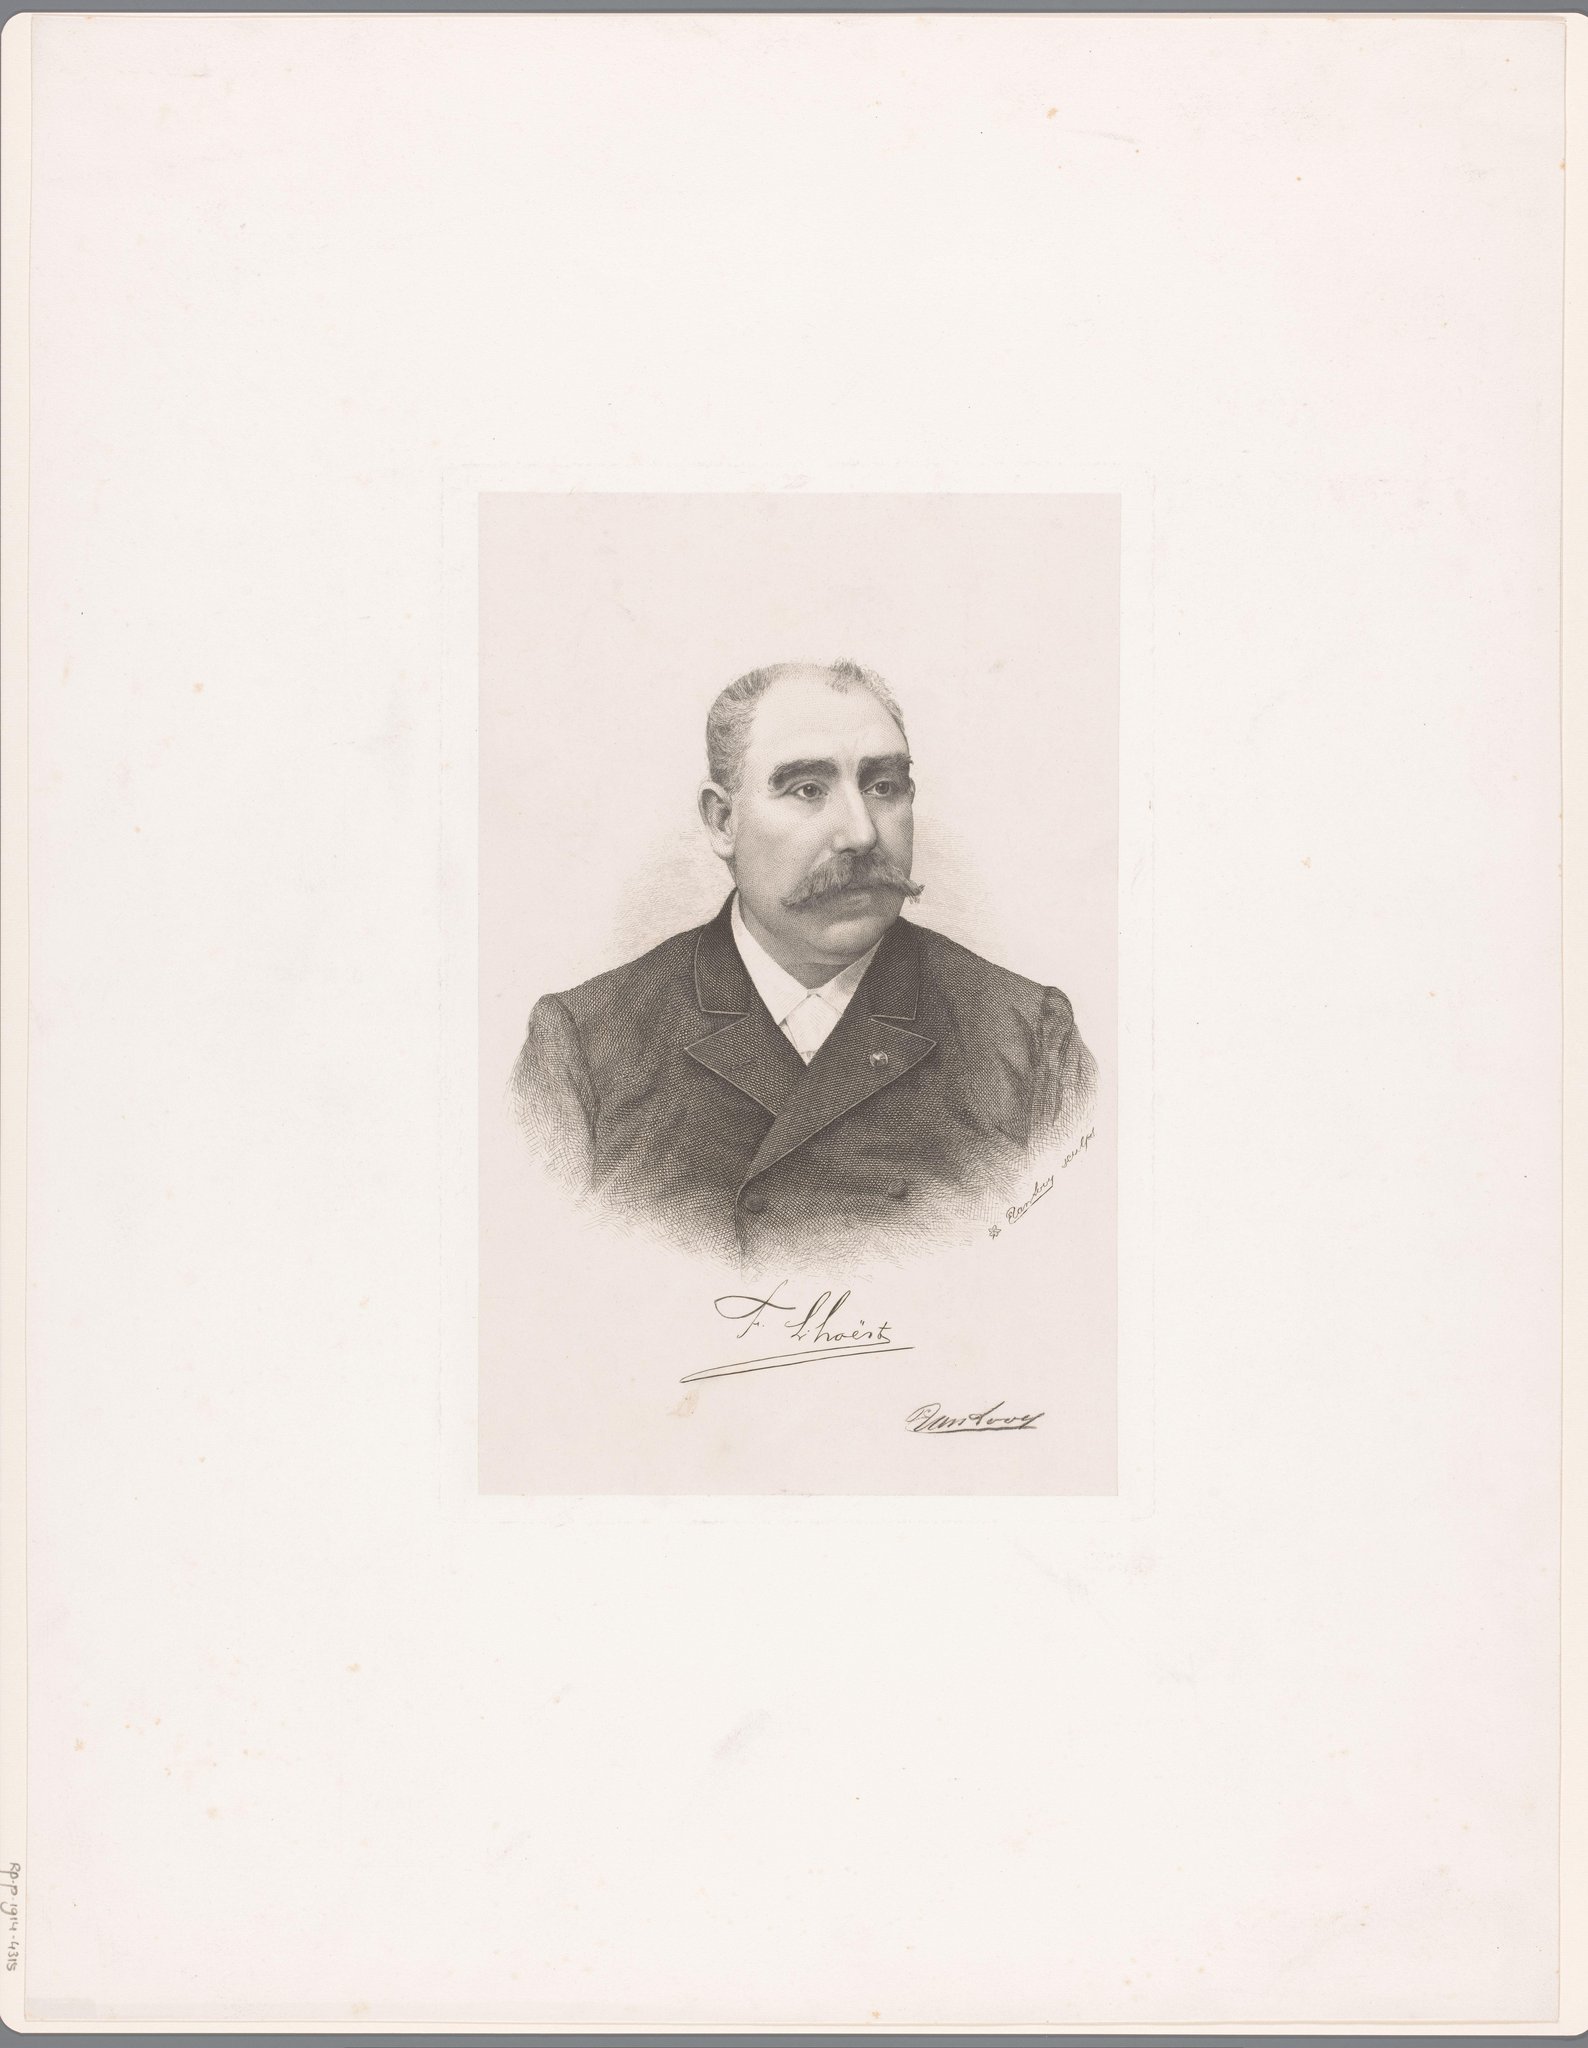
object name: print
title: Portret van François L'Hoëst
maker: joseph edouard van looy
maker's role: print maker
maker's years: 1871-1896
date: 1881-1914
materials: paper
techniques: etching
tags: historical persons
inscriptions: collector's mark: Lugt 2228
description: Sterfdatum van de prentmaker is onbekend. Daarom is voor de bepaling van de rechten van dit object gebruik gemaakt van de verwervingsdatum Rijksmuseum Amsterdam.